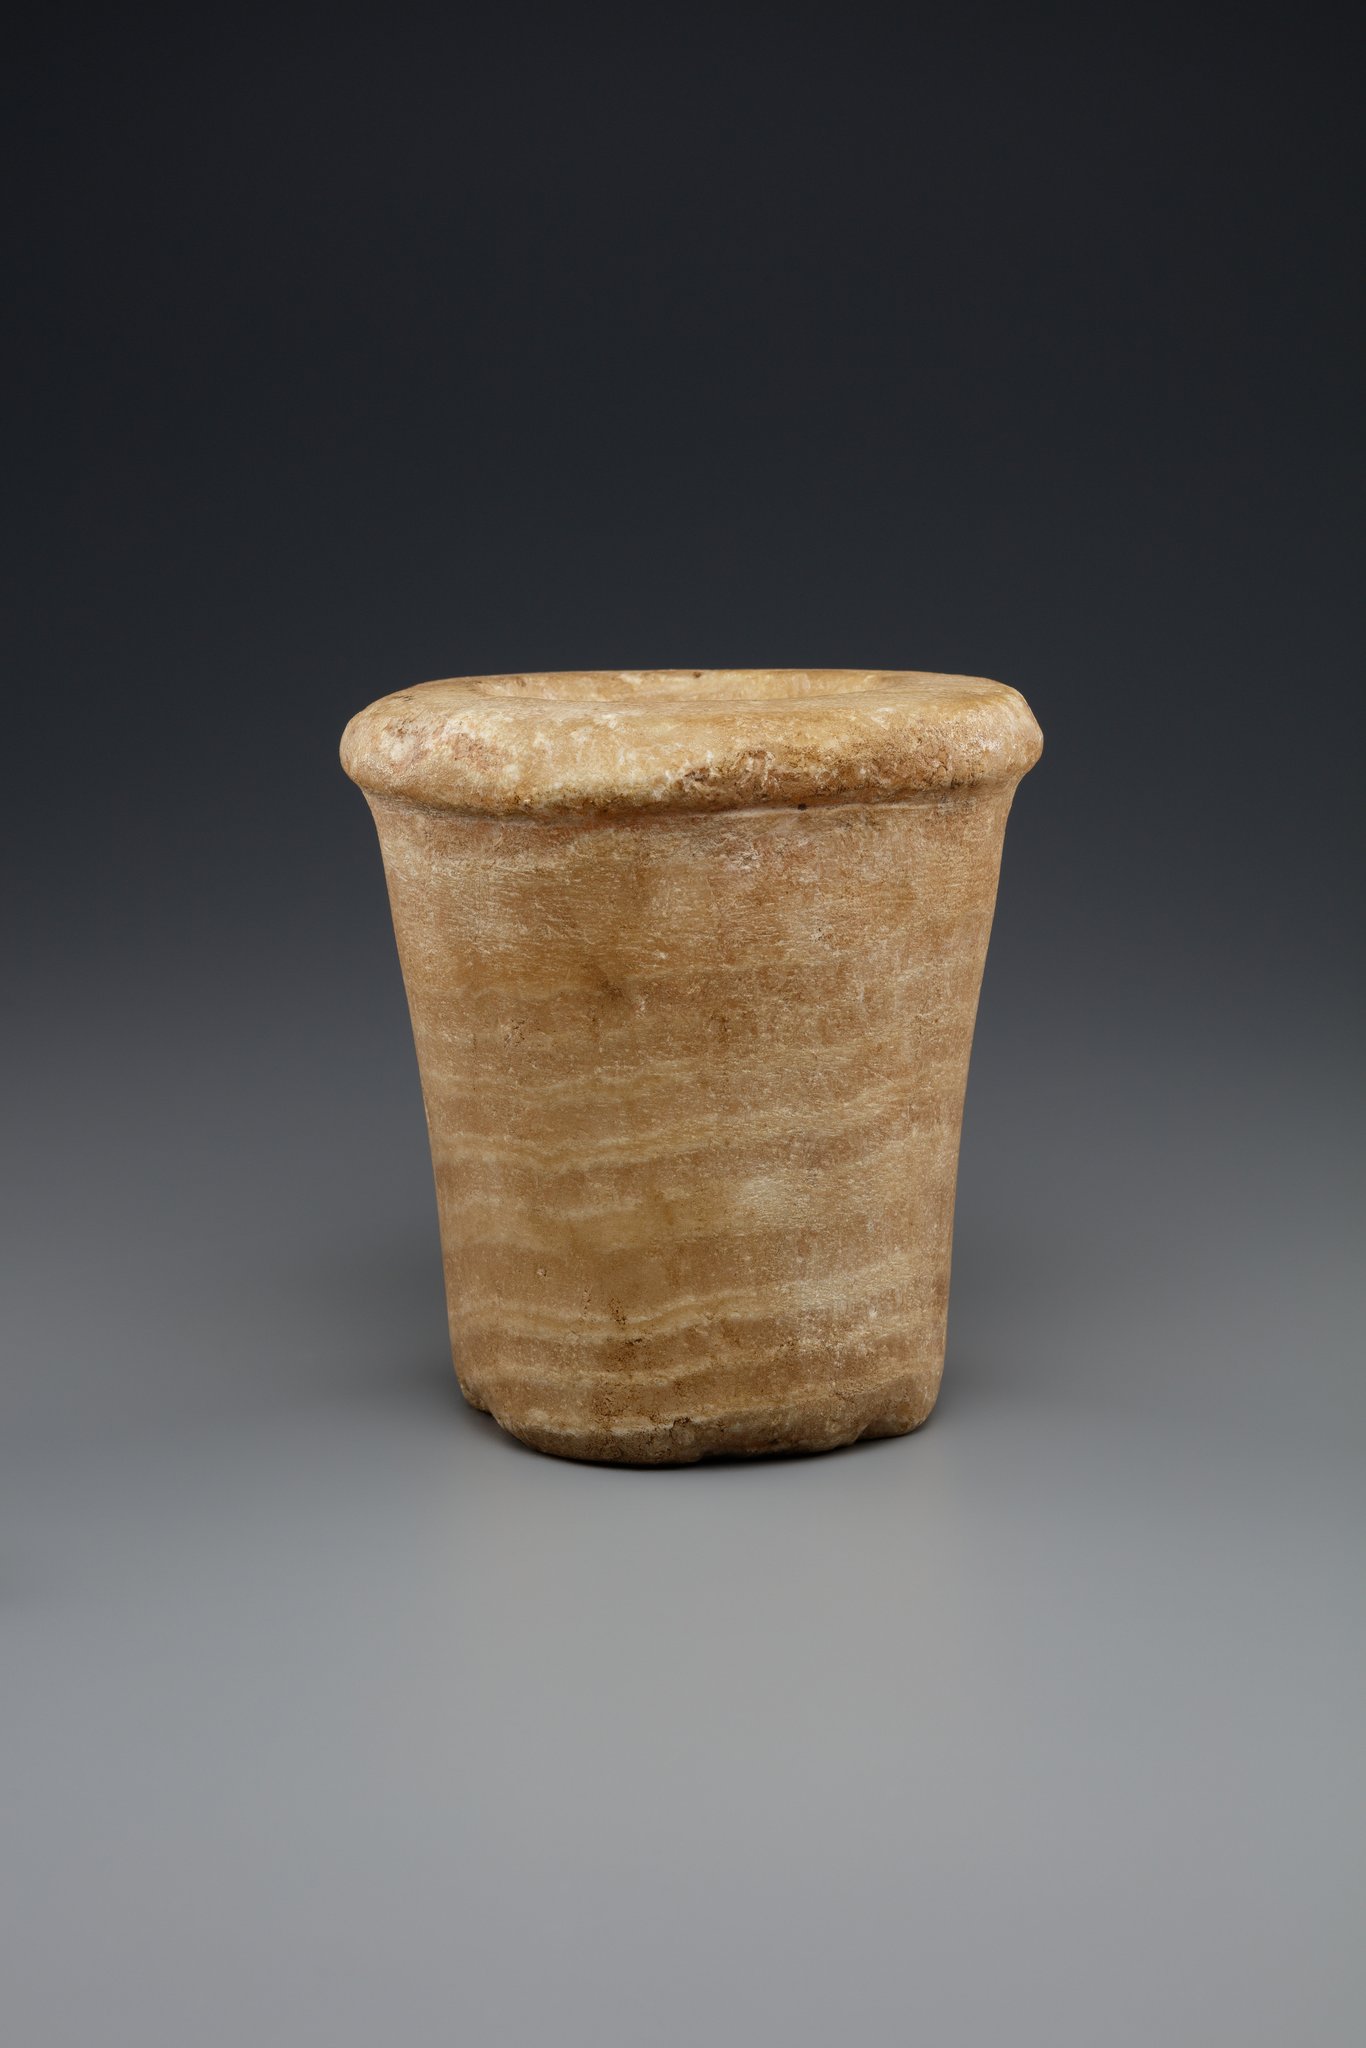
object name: jar, cylindrical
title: Cylinder jar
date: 3100-2649 BCE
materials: stone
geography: egypt